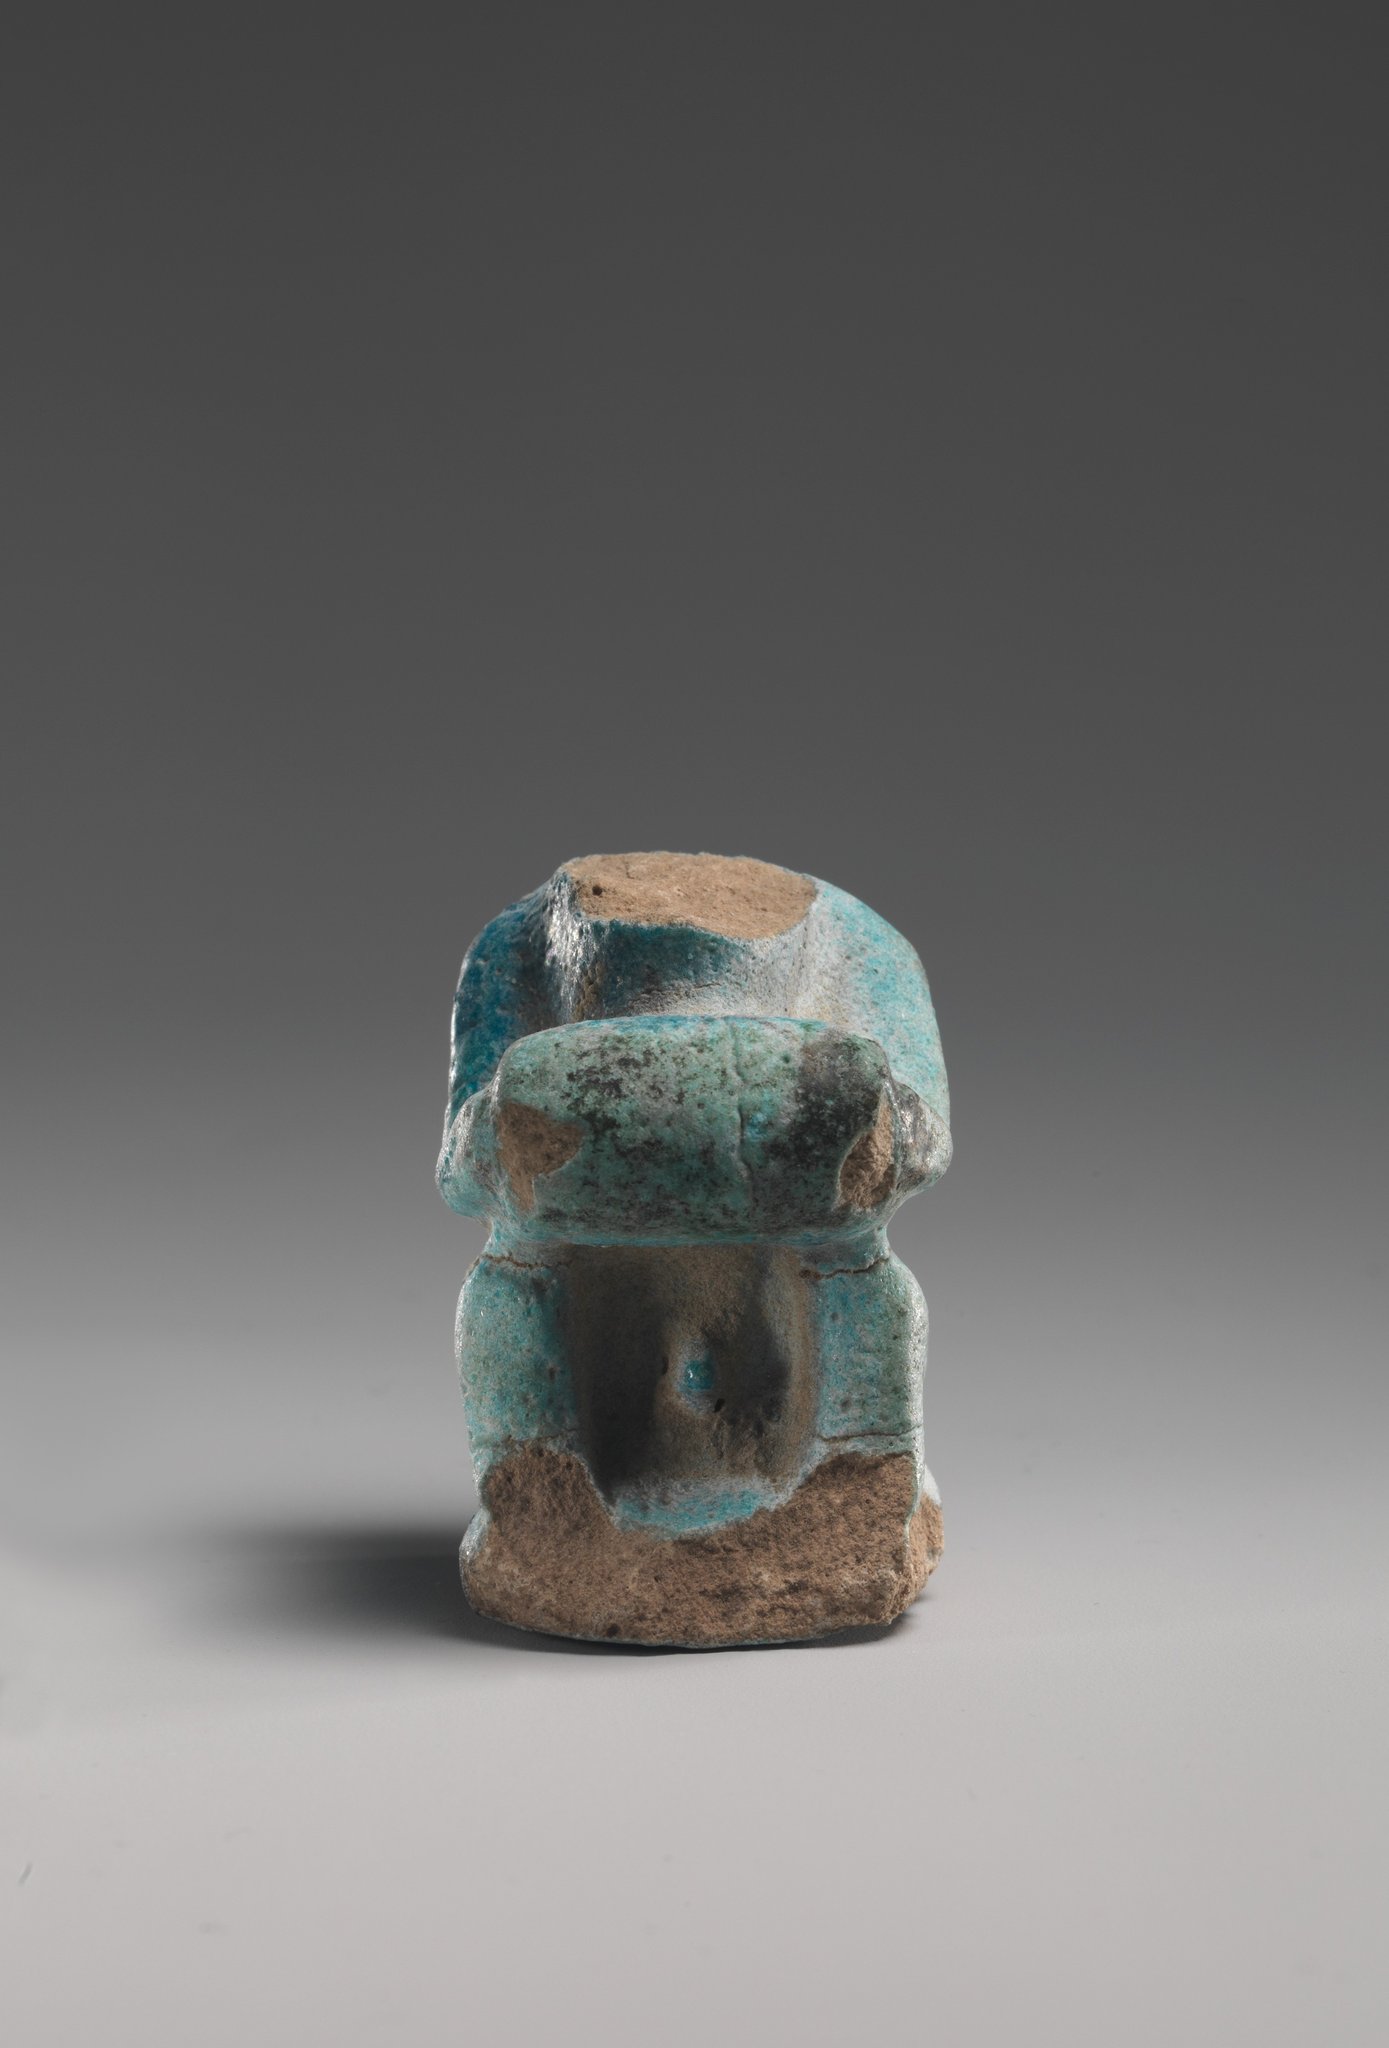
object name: figurine fragment, dwarf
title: Fragment of dwarf figurine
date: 1981-1640 BCE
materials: faience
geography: egypt